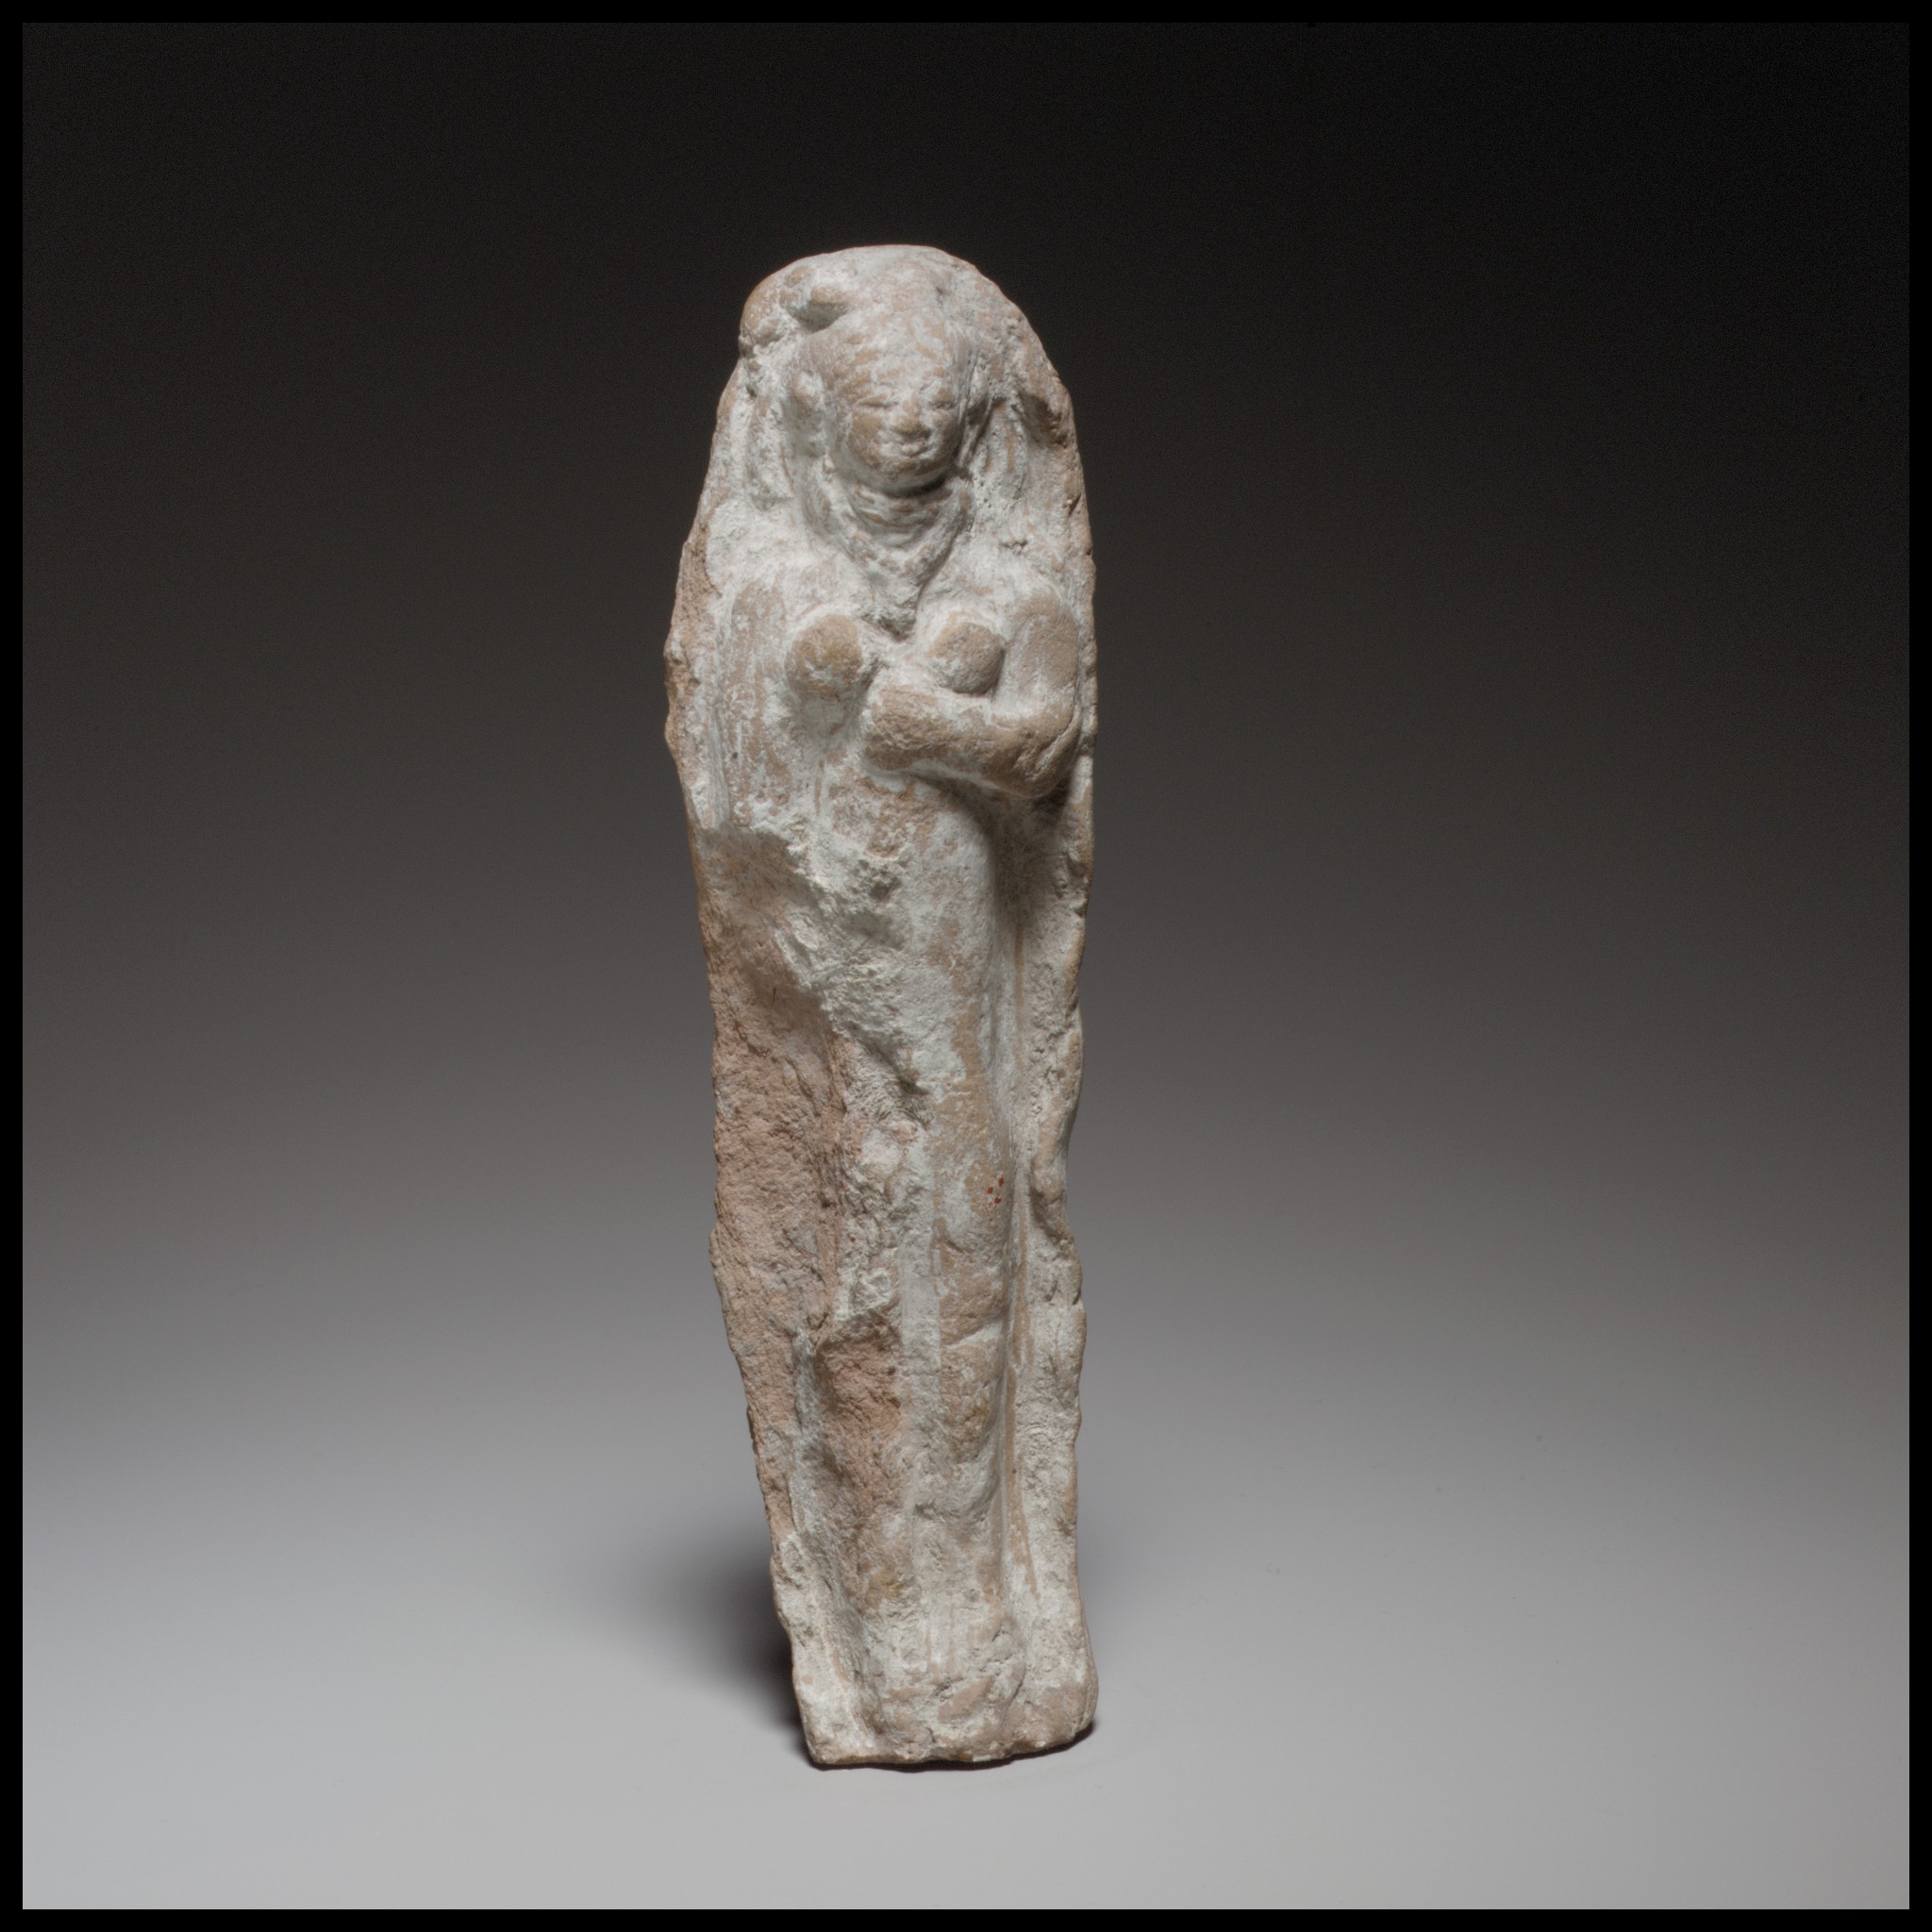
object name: statuette of a woman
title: Standing female figurine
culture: cypriot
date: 600-480 BCE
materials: terracotta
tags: female nudes